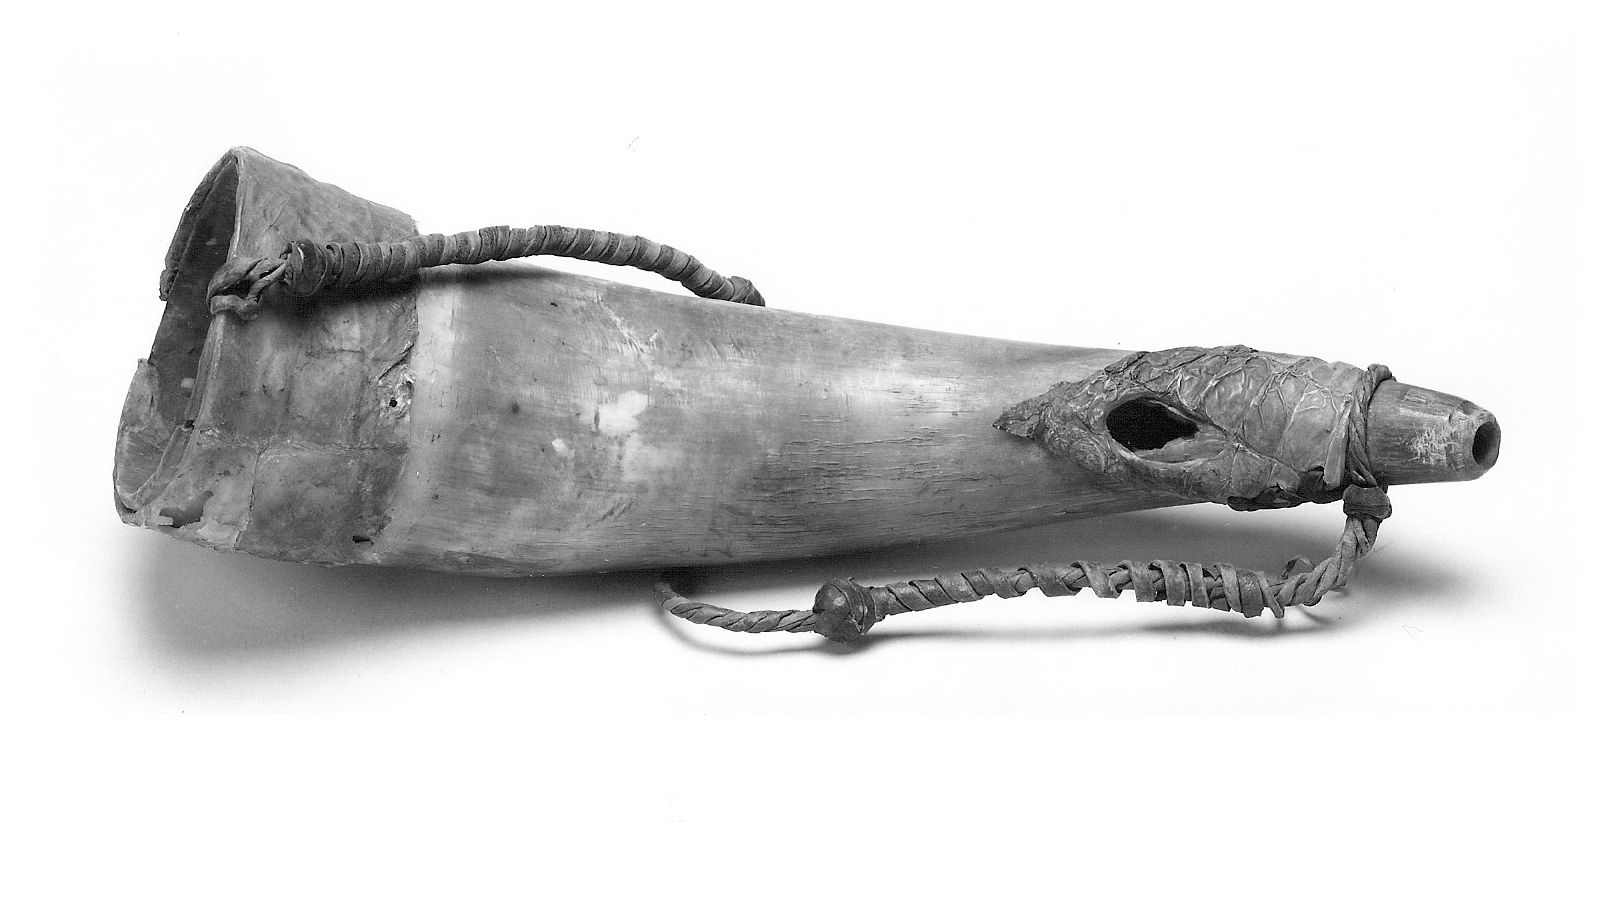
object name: horn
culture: tanzanian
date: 1867-1900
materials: horn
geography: tanzania